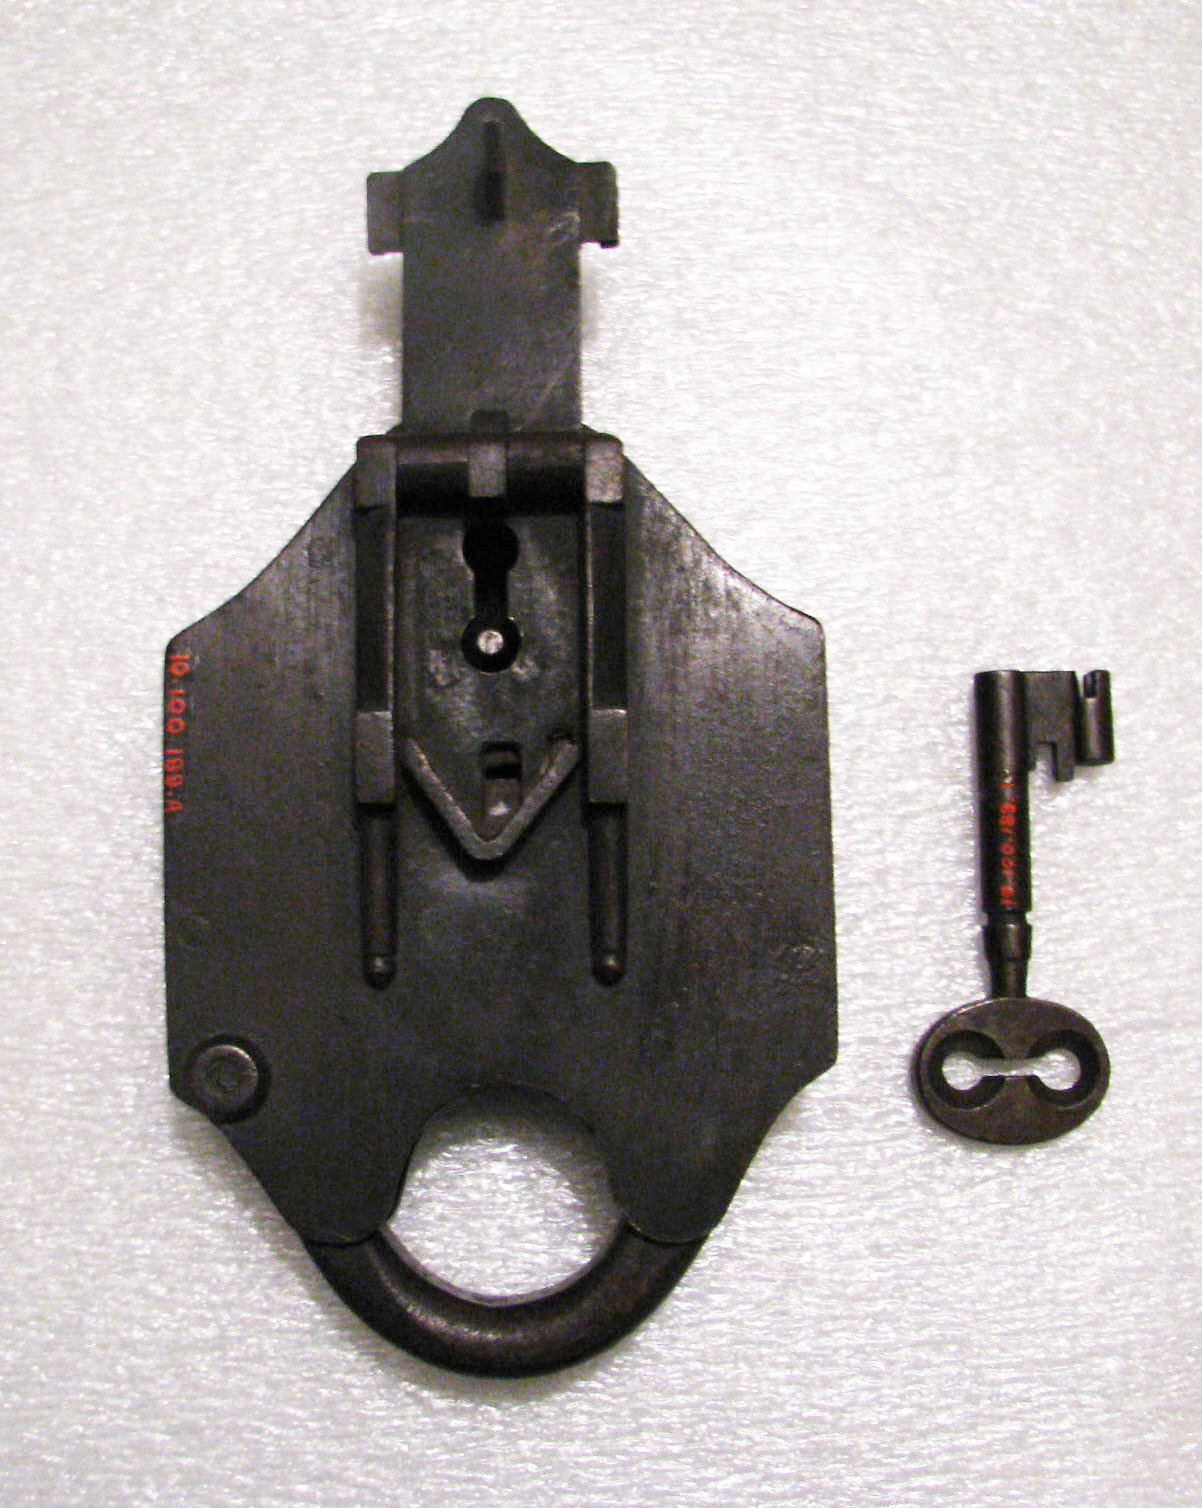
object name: padlock with key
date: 1701-1800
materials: iron